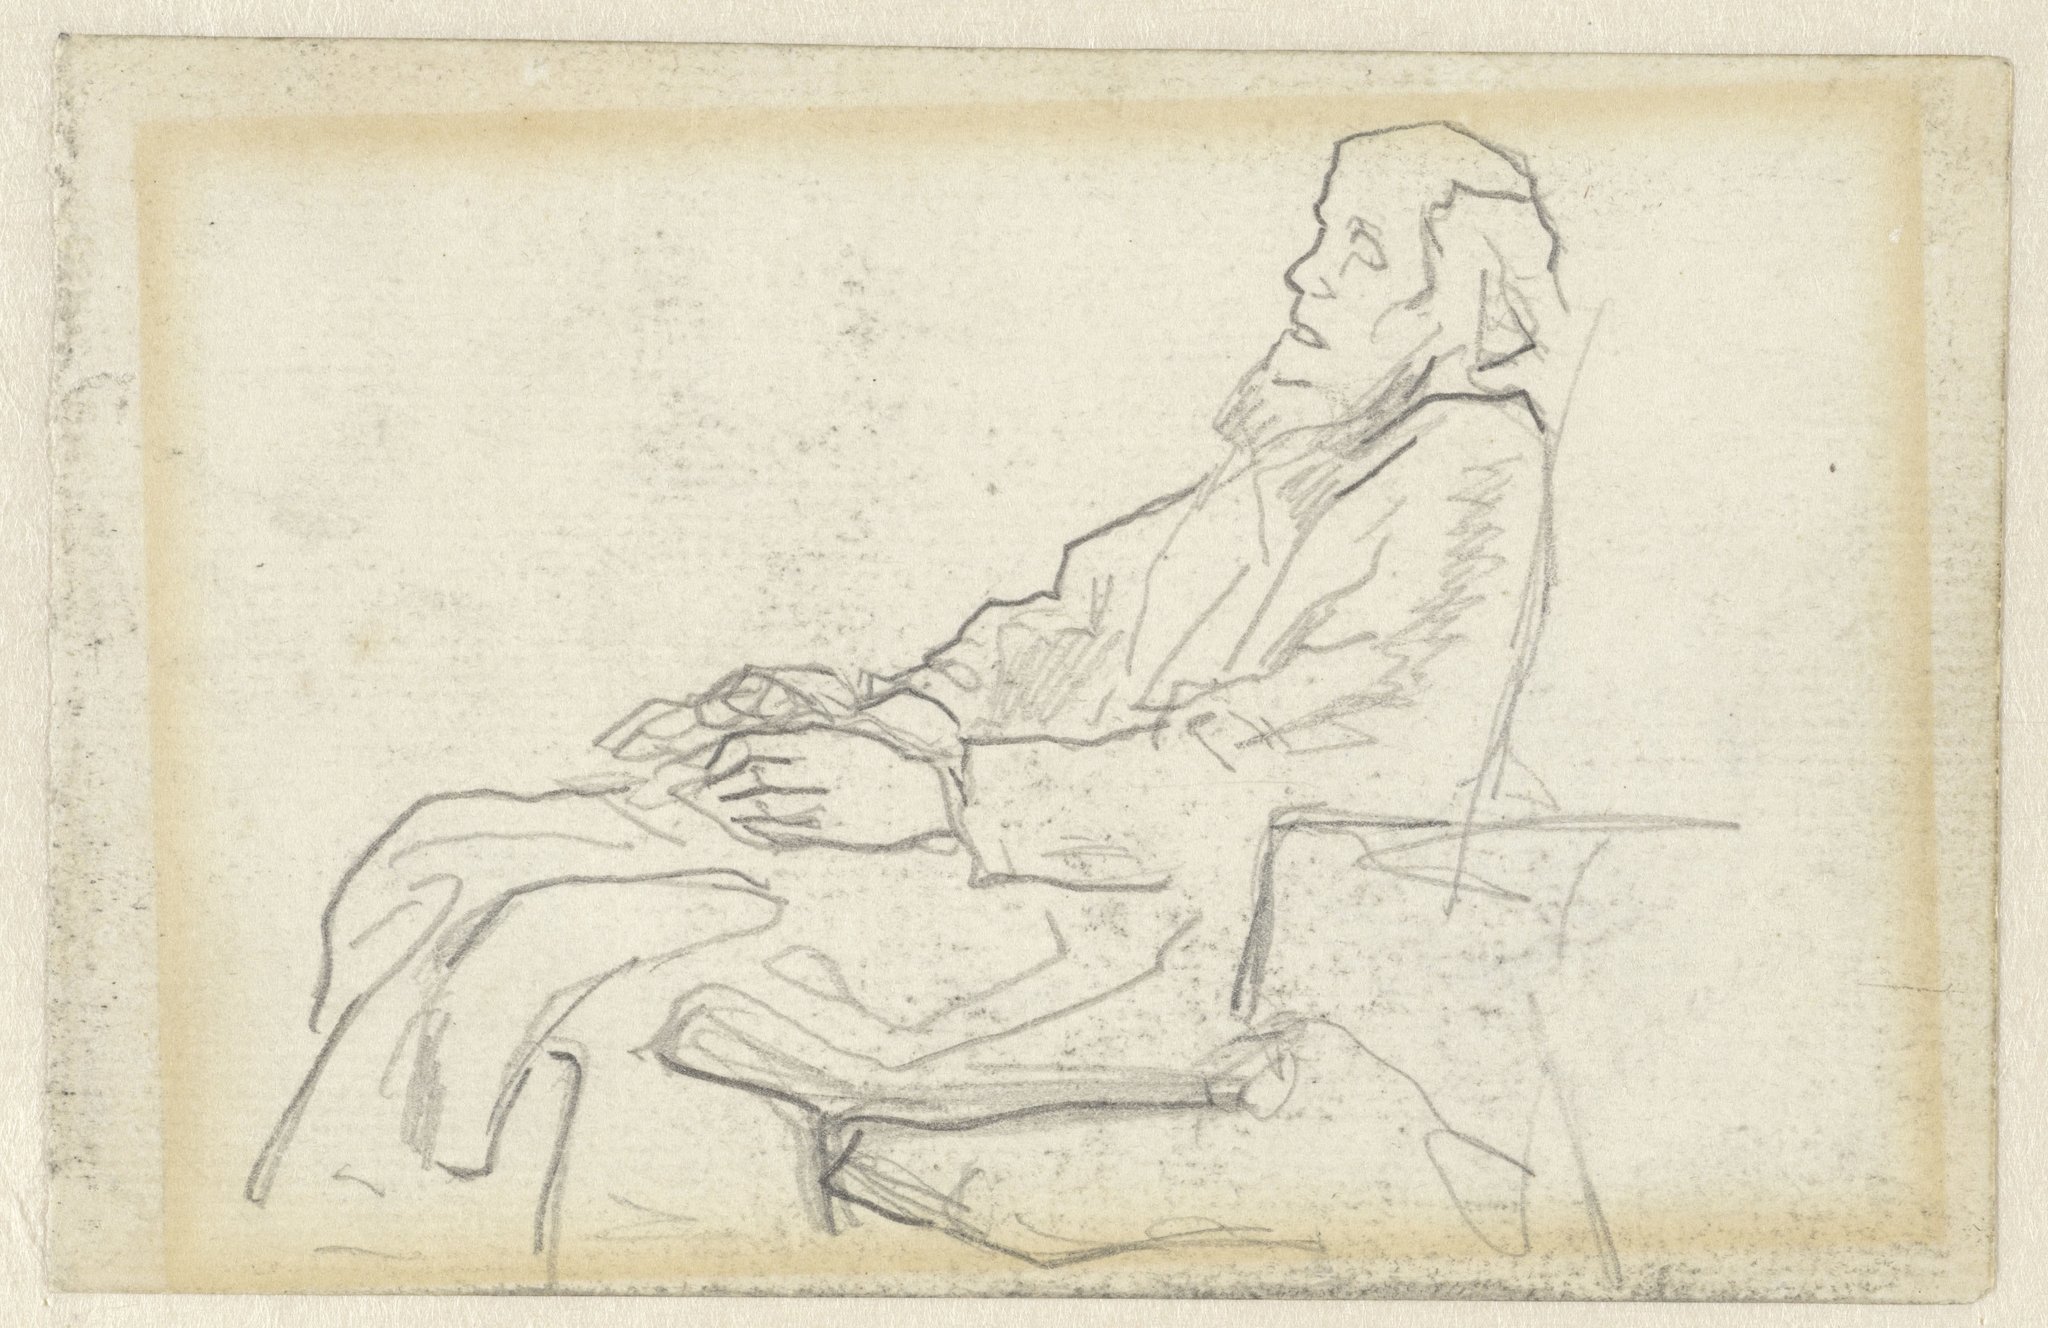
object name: drawing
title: Zittende grijsaard, naar links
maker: jacob maris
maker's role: draughtsman, painter, print maker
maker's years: 1837-1899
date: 1847-1899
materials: paper, pencil